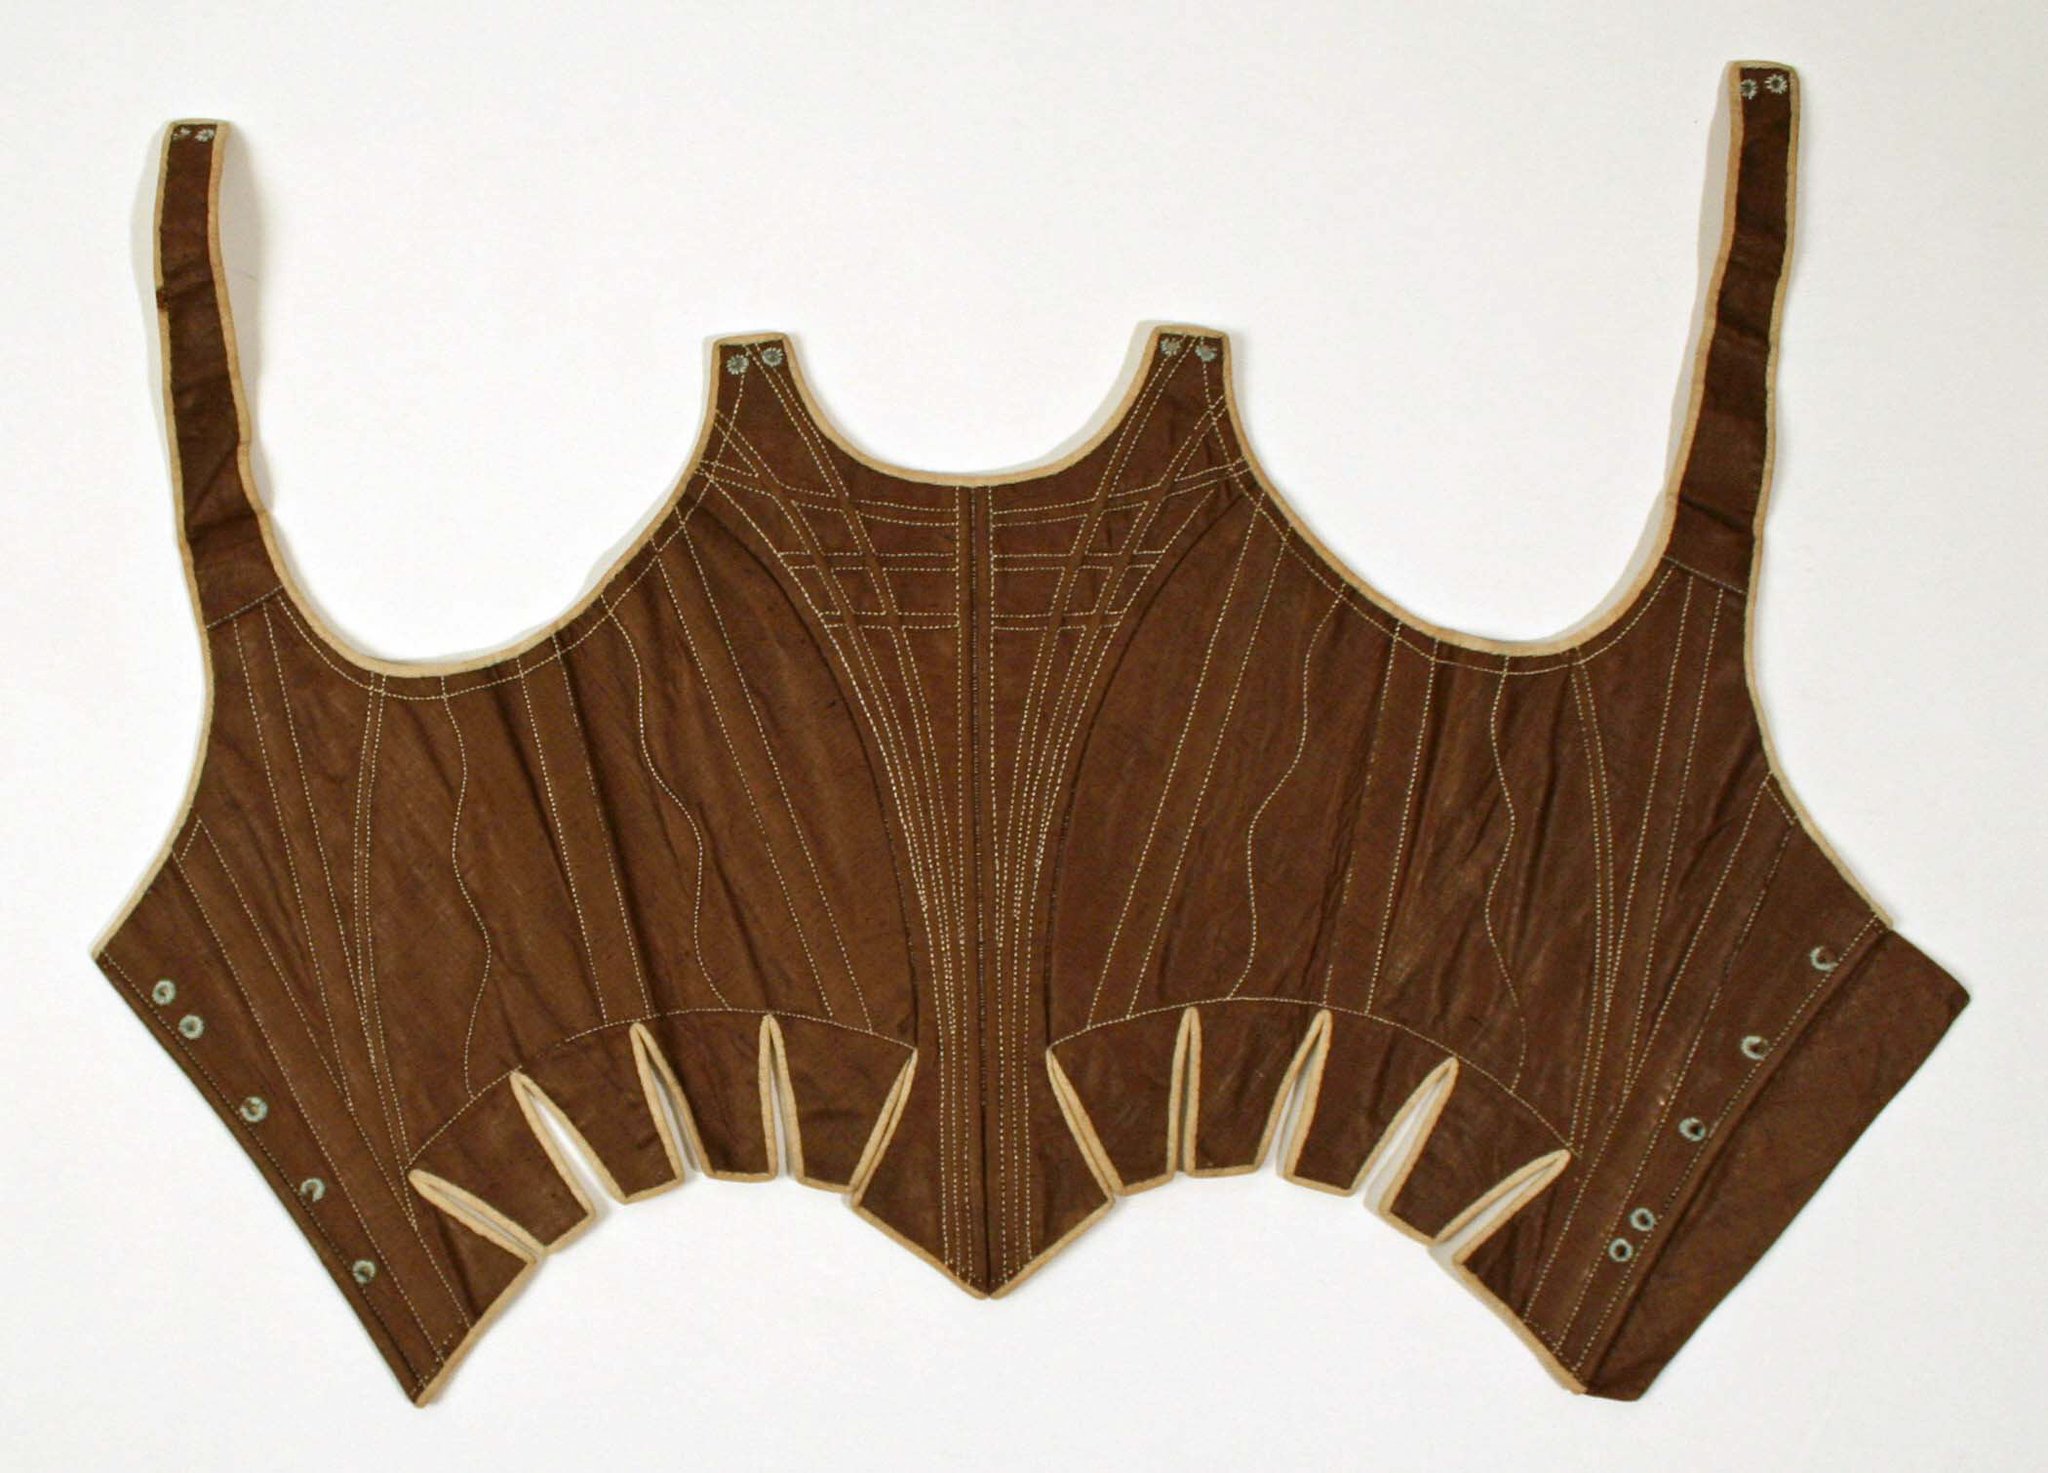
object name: corset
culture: european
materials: cotton, wood